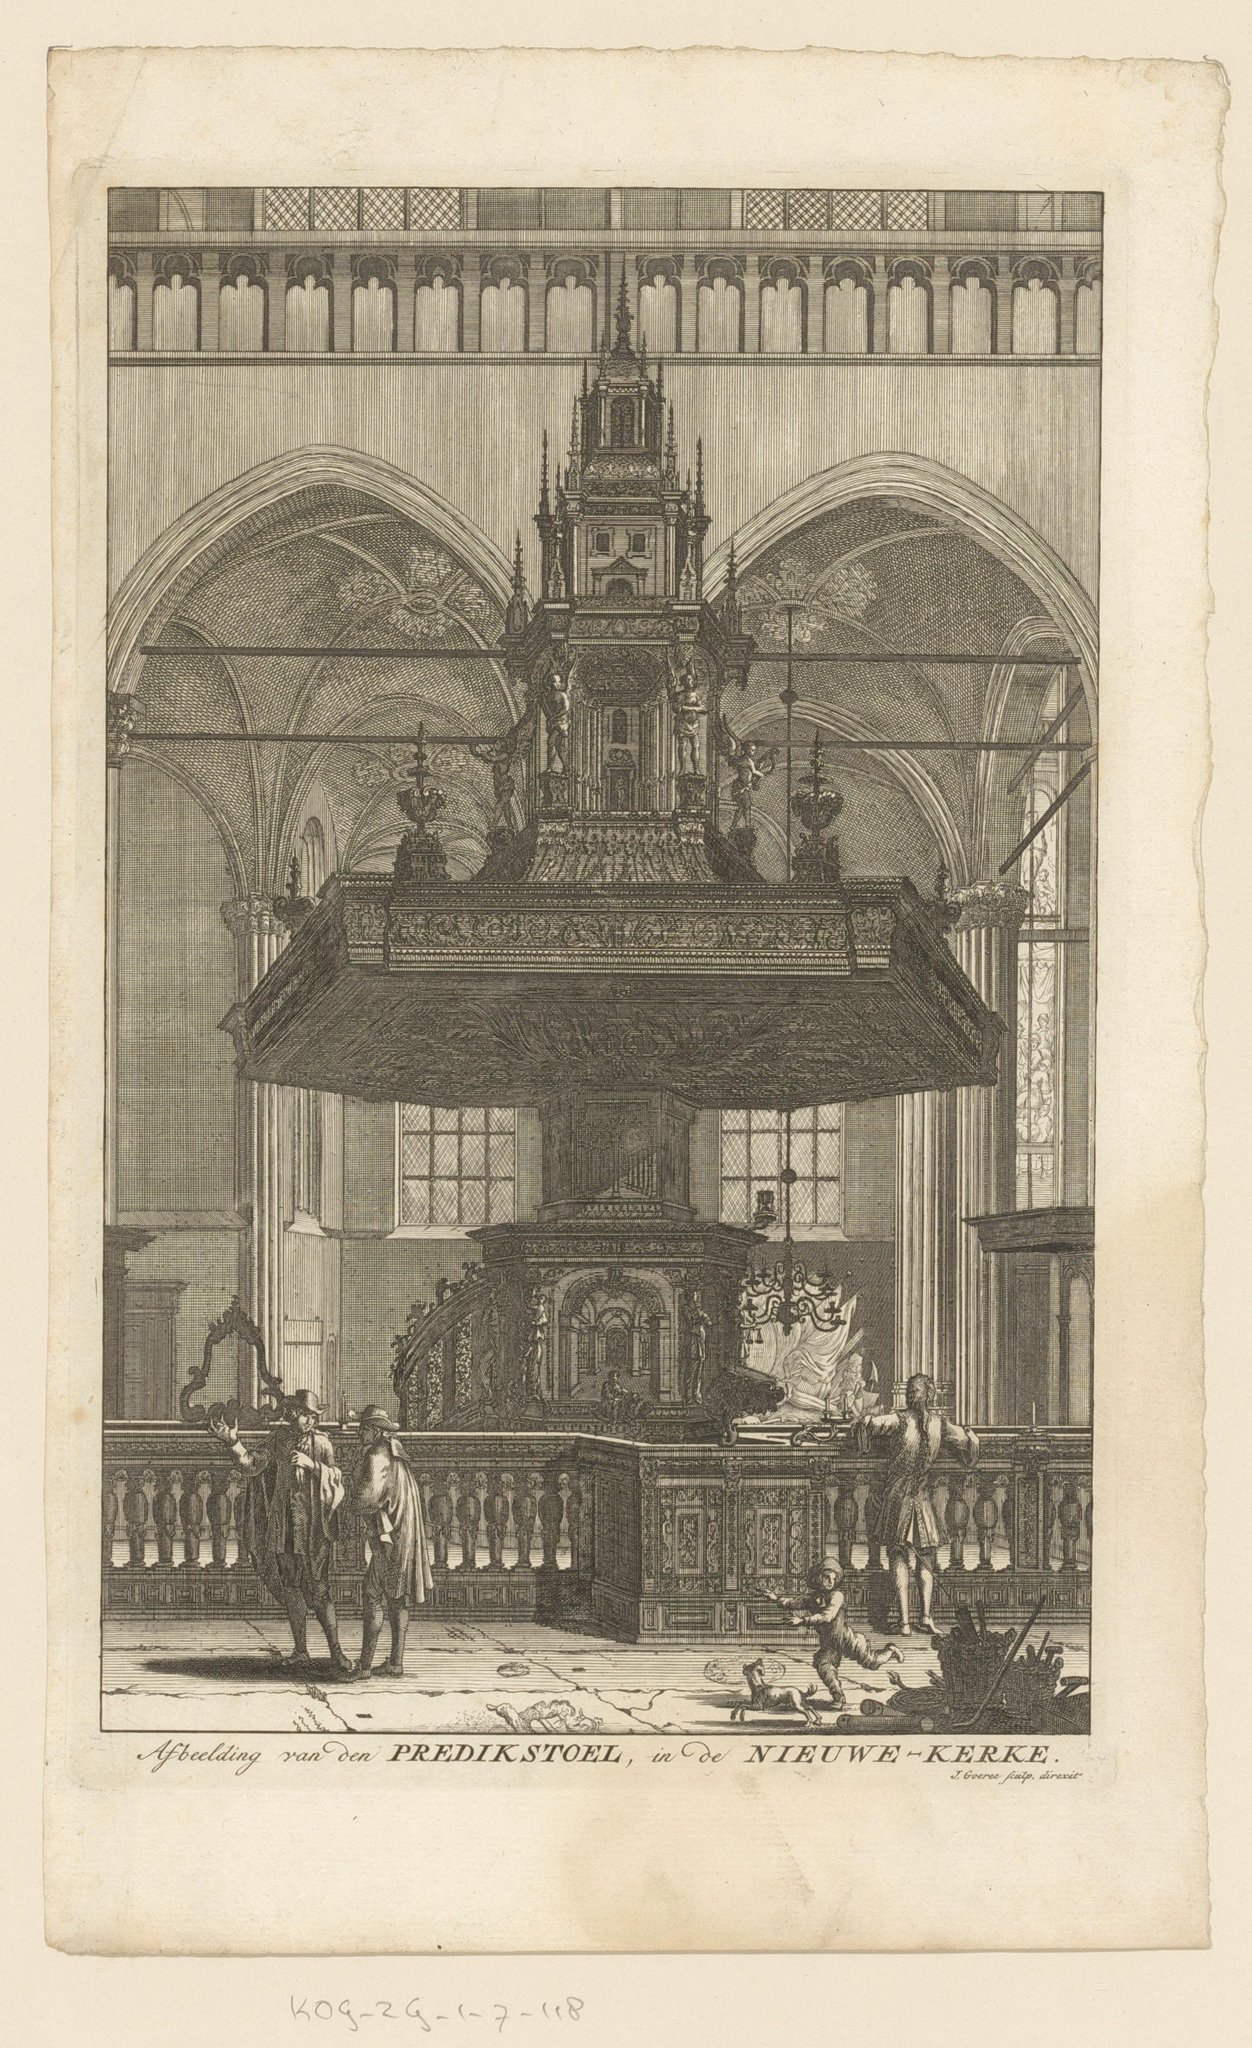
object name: print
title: Preekstoel in de Nieuwe Kerk in Amsterdam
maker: jan goeree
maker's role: draughtsman, print maker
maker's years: 1670-1731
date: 1780-1782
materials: paper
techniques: engraving, etching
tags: interior of church, pulpit, ambo, chancel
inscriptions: stamp, stamp, collector's mark: Lugt 1641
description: Gezicht op de tussen 1649 en 1664 door Albert Jansz. Vinckenbrinck vervaardigde preekstoel in de Nieuwe Kerk te Amsterdam. Onderwerpsrubrieken binnen de Atlas Zeden en Gewoonten: Godsdienst, Kerkgebouwen te Amsterdam.